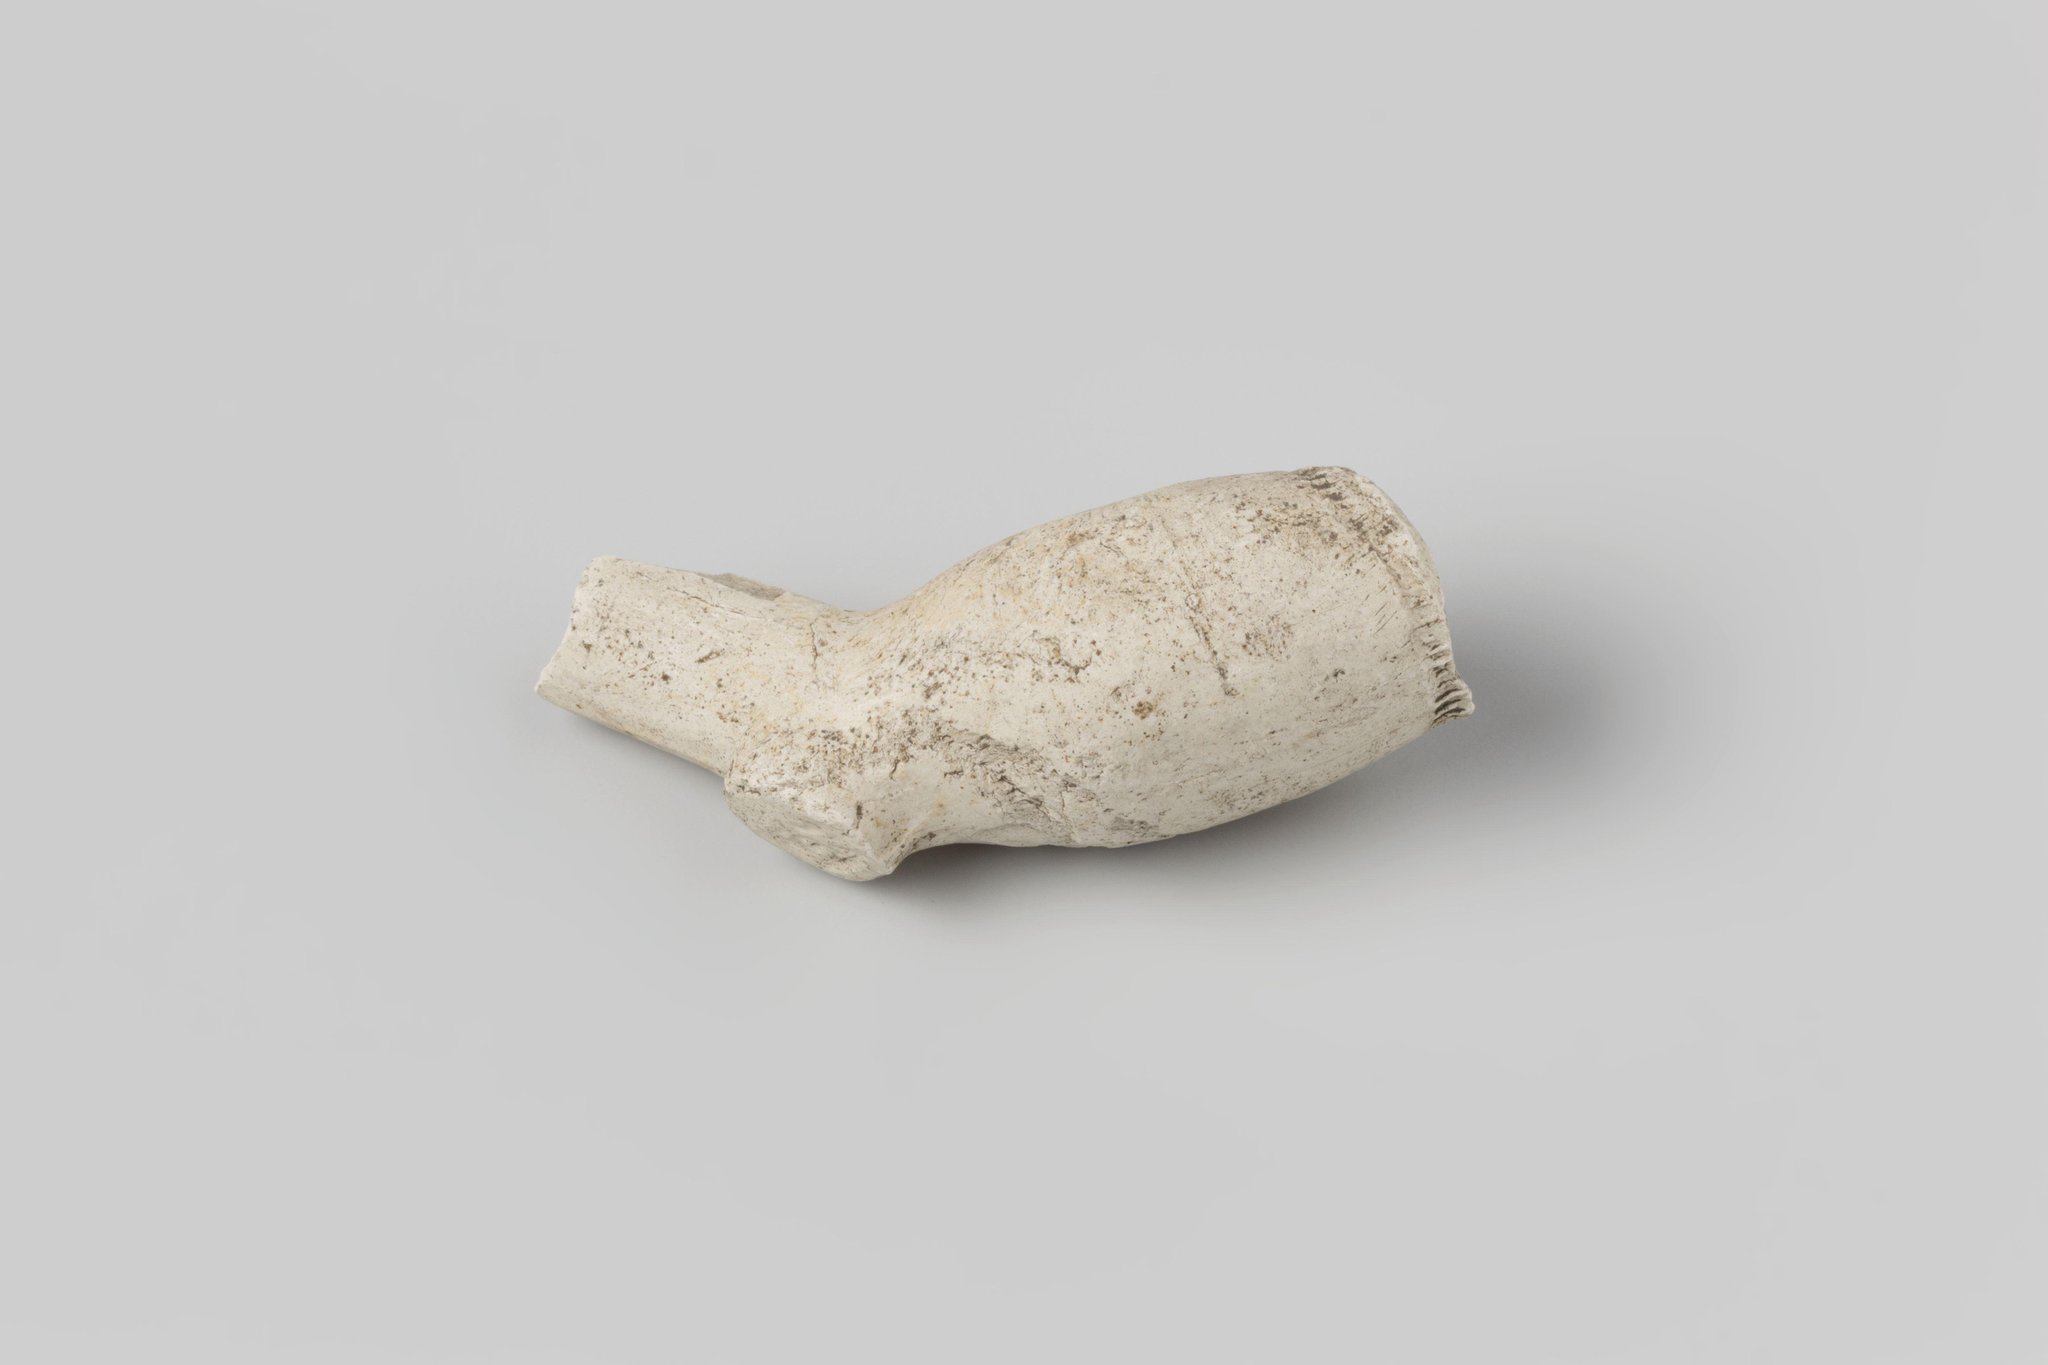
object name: pipe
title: Fragment tabakspijp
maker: Anonymous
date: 1660-1680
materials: clay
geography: gouda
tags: rotterdam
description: Fragment tabakspijp. Van de opgravingen op de Hofstede Arentsburg 1827-1831 onder toezicht van Professor Reuvens.